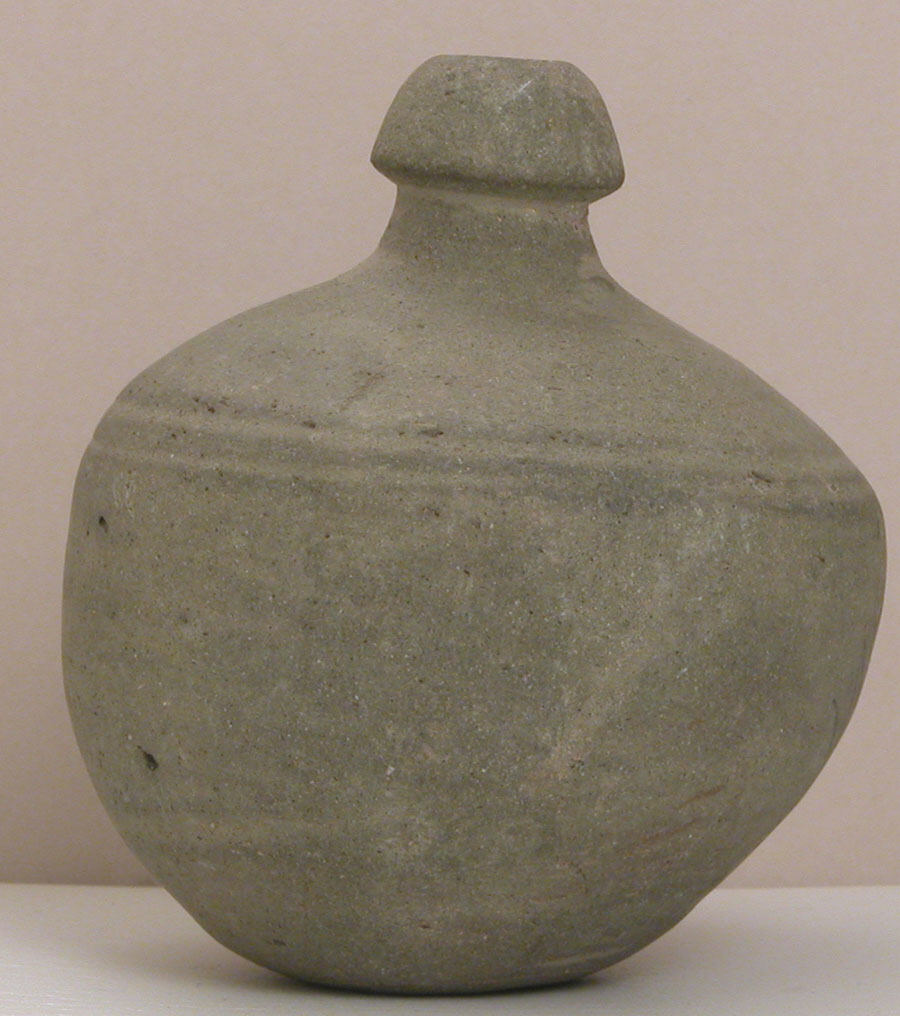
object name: vessel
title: Spheroconical Vessel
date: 801-1000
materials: earthenware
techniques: incising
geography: iran